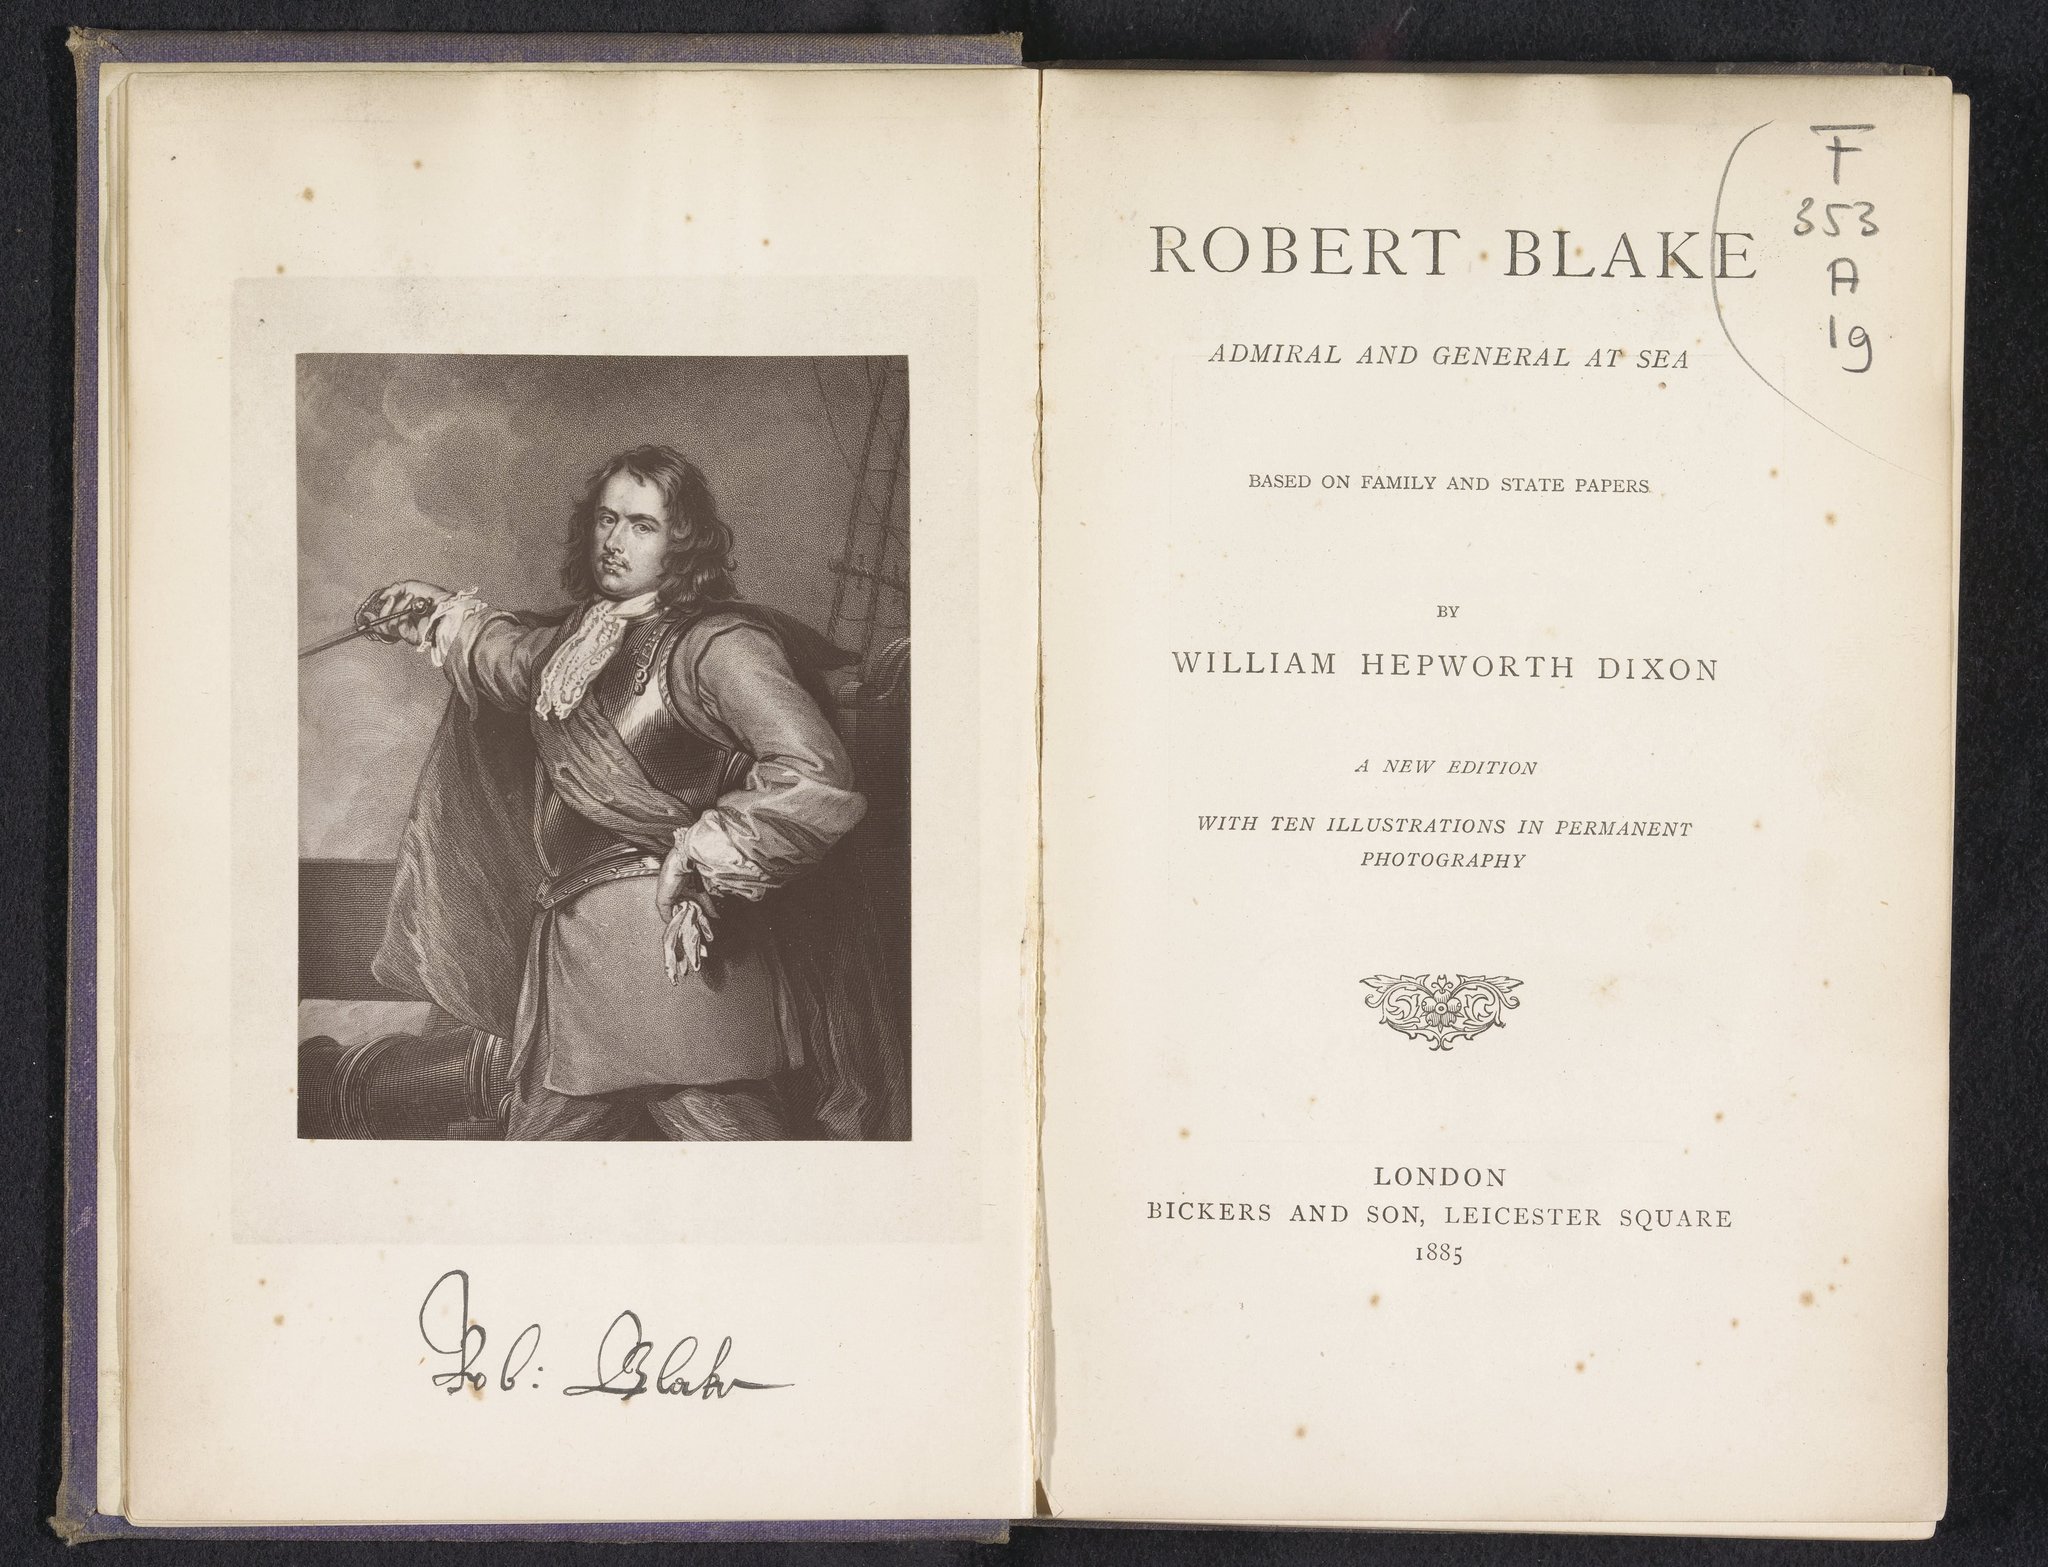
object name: book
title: Robert Blake admiral and general at sea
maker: william hepworth dixon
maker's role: historicus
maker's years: 1821-1879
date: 1885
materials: cardboard, linen, paper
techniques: printing, woodburytype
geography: london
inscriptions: inscription: ‘ex libris SFJ’, name: ‘F. W. Newland’